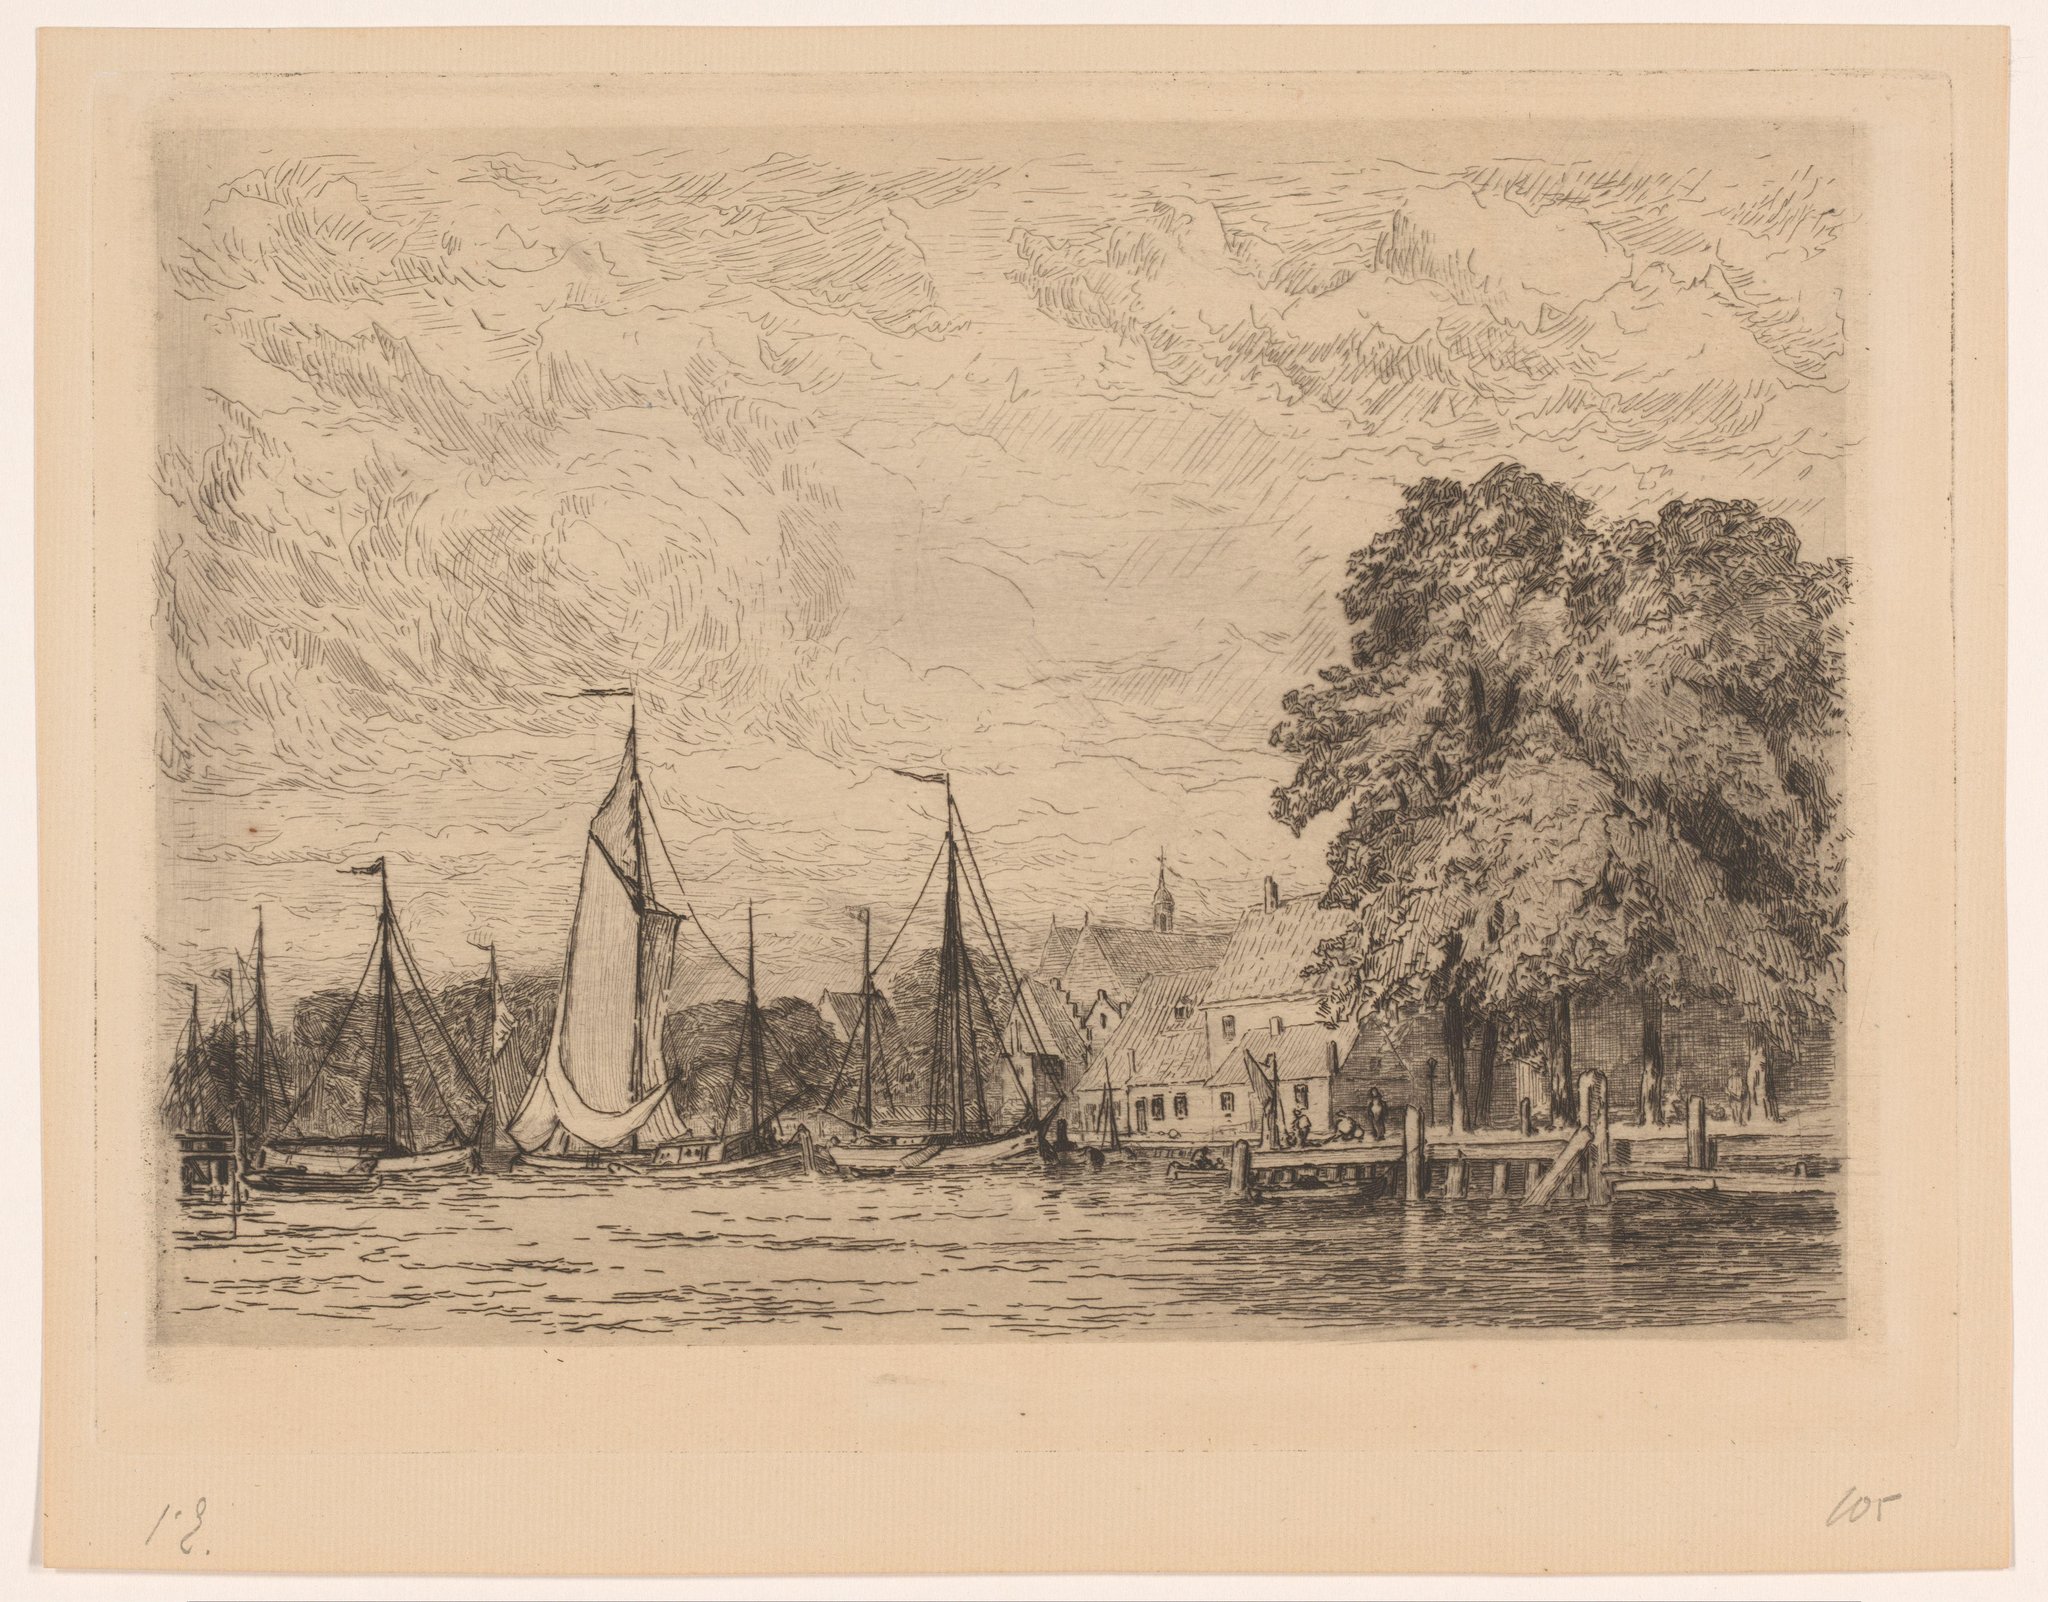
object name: print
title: Riedijkshaven in Dordrecht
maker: carel nicolaas storm van s-gravesande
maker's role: draughtsman, print maker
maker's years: 1841-1924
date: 1880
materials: paper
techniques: drypoint, etching, intaglio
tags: harbour, dordrecht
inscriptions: collector's mark: Lugt 2228